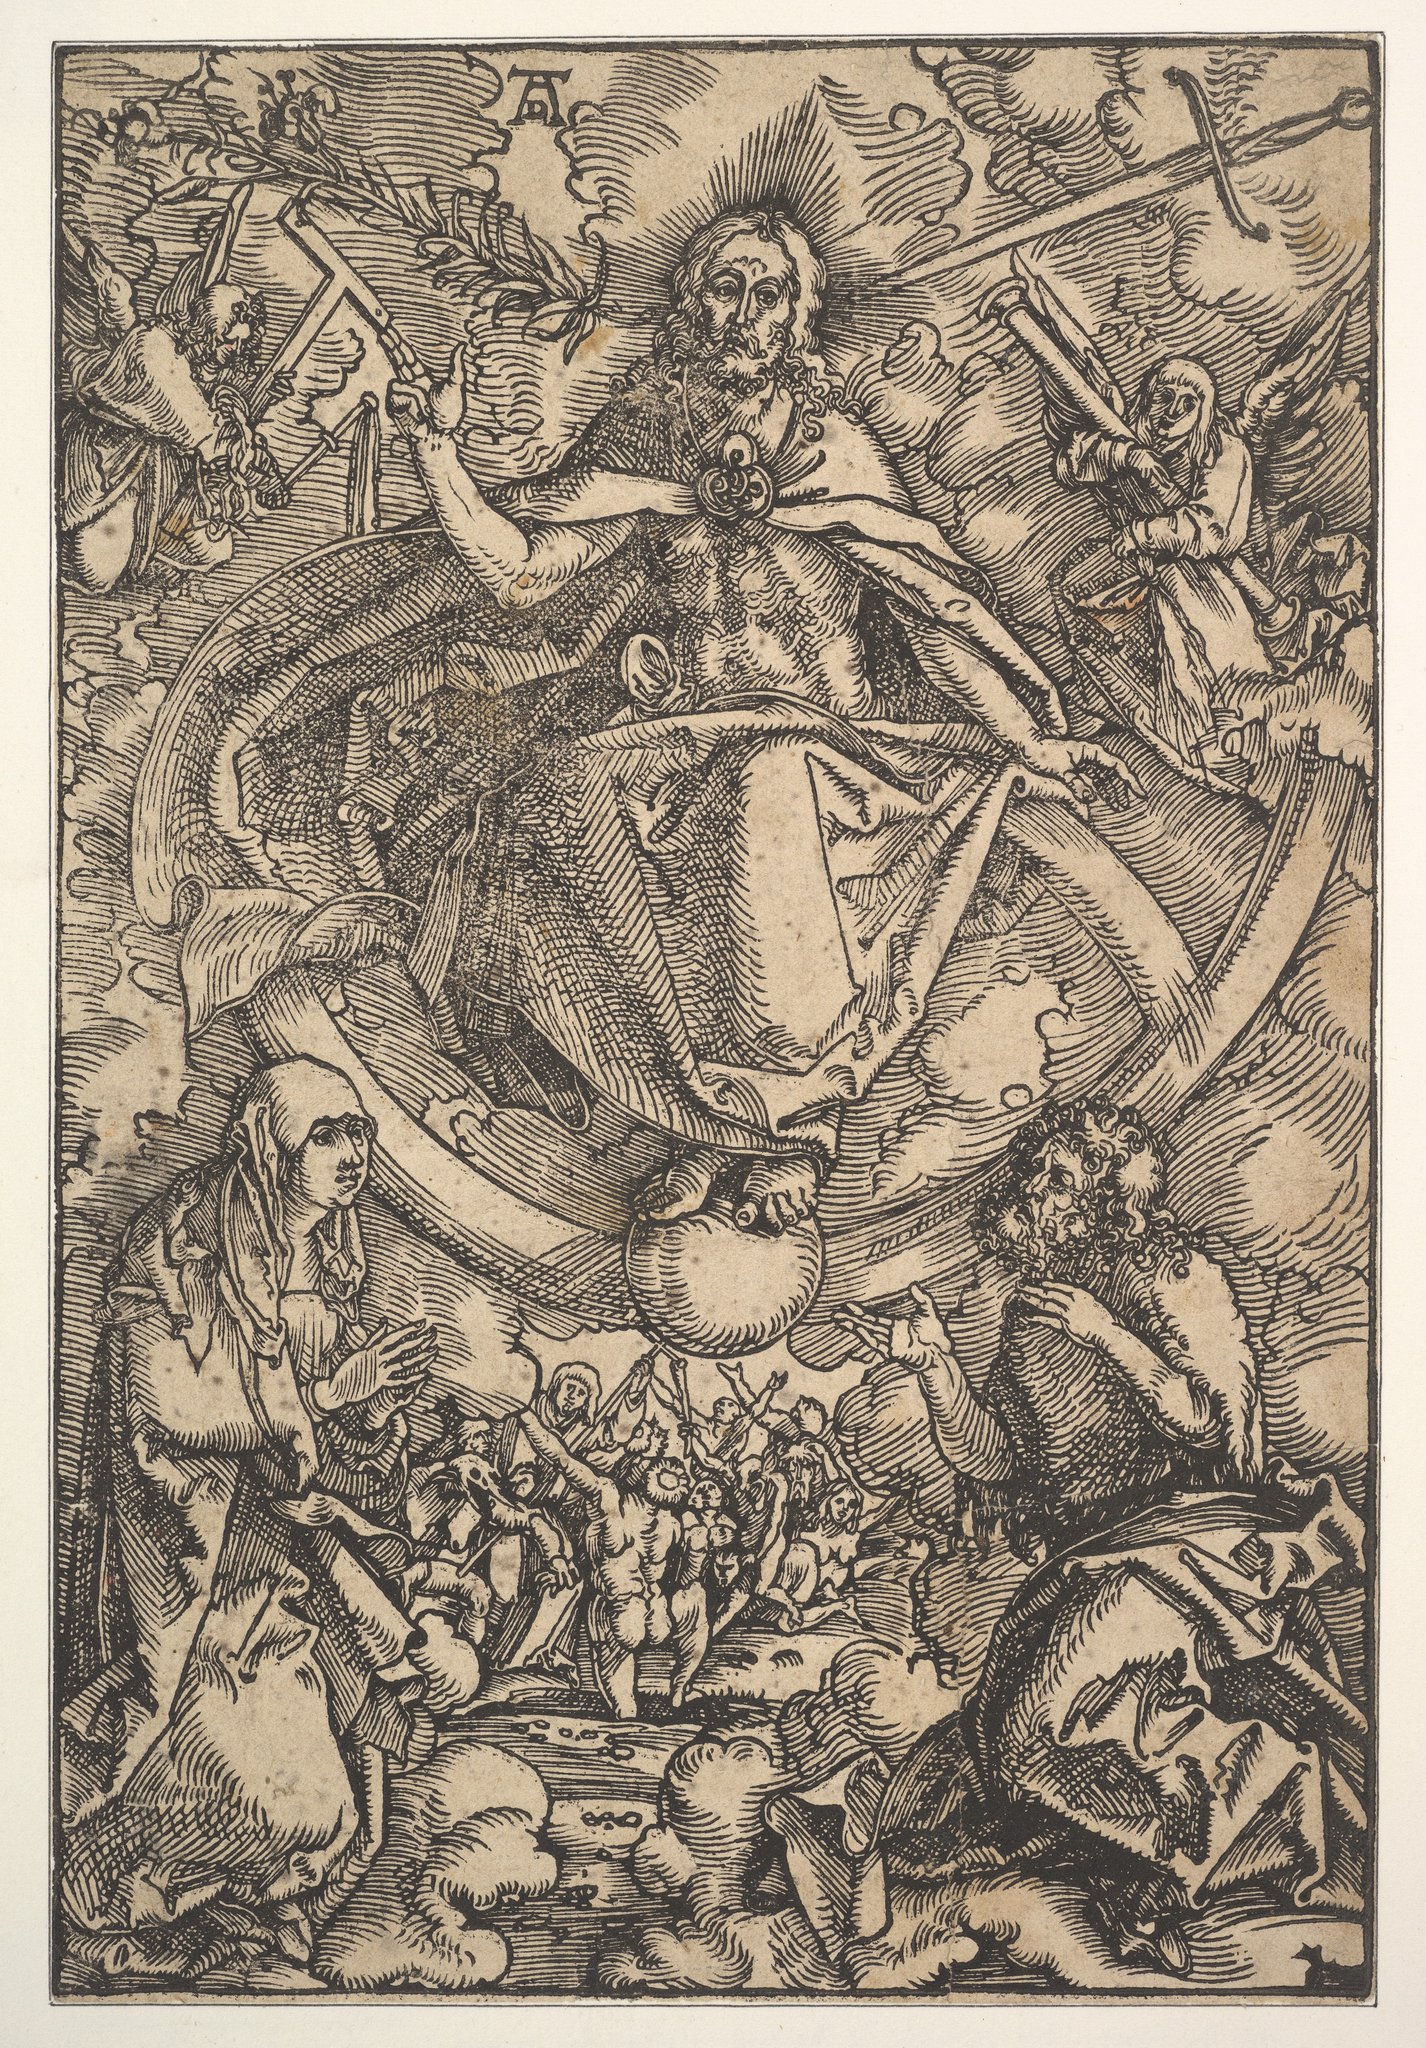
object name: print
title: The Last Judgment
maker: hans baldung (called hans baldung grien)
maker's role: artist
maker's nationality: german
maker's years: 1484-1545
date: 1505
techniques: woodcut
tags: men,angels,christ,last judgement